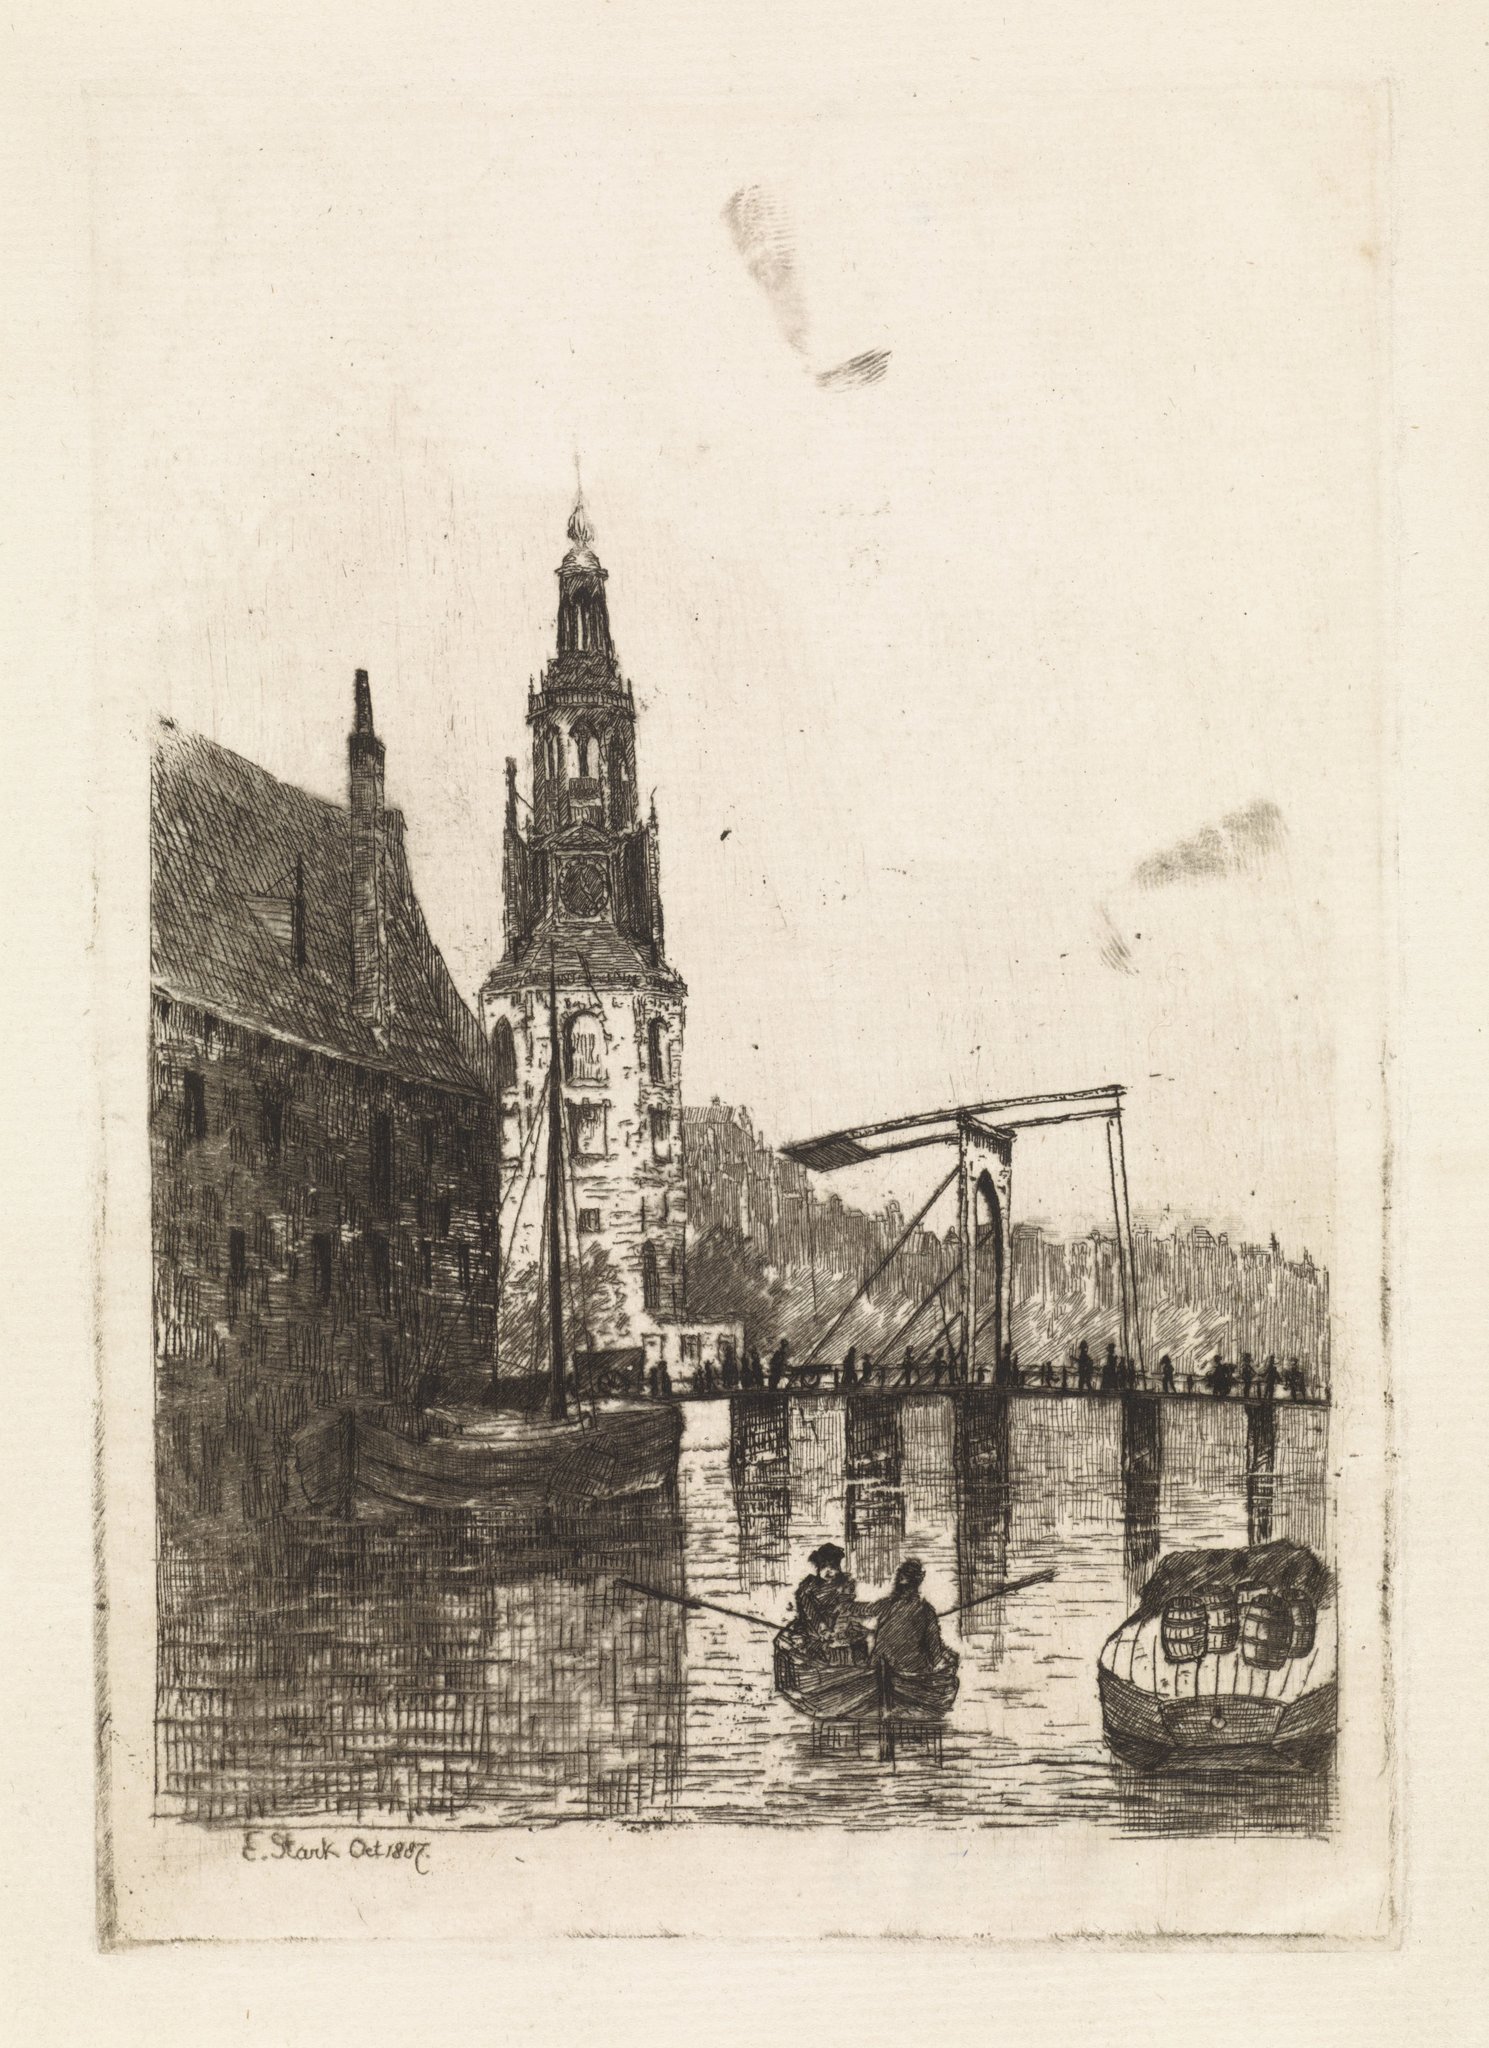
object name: print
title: Montelbaanstoren te Amsterdam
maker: elias stark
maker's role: draughtsman, print maker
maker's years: 1849-1933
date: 1810-1887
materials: paper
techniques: etching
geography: nieuwer-amstel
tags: tower, clock tower ~ monumental adornment, canals, waters (in city)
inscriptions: collector's mark: Lugt 2228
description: De Montelbaanstoren met daarnaast een ophaalbrug over de gracht. Op de voorgrond een roeibootje.